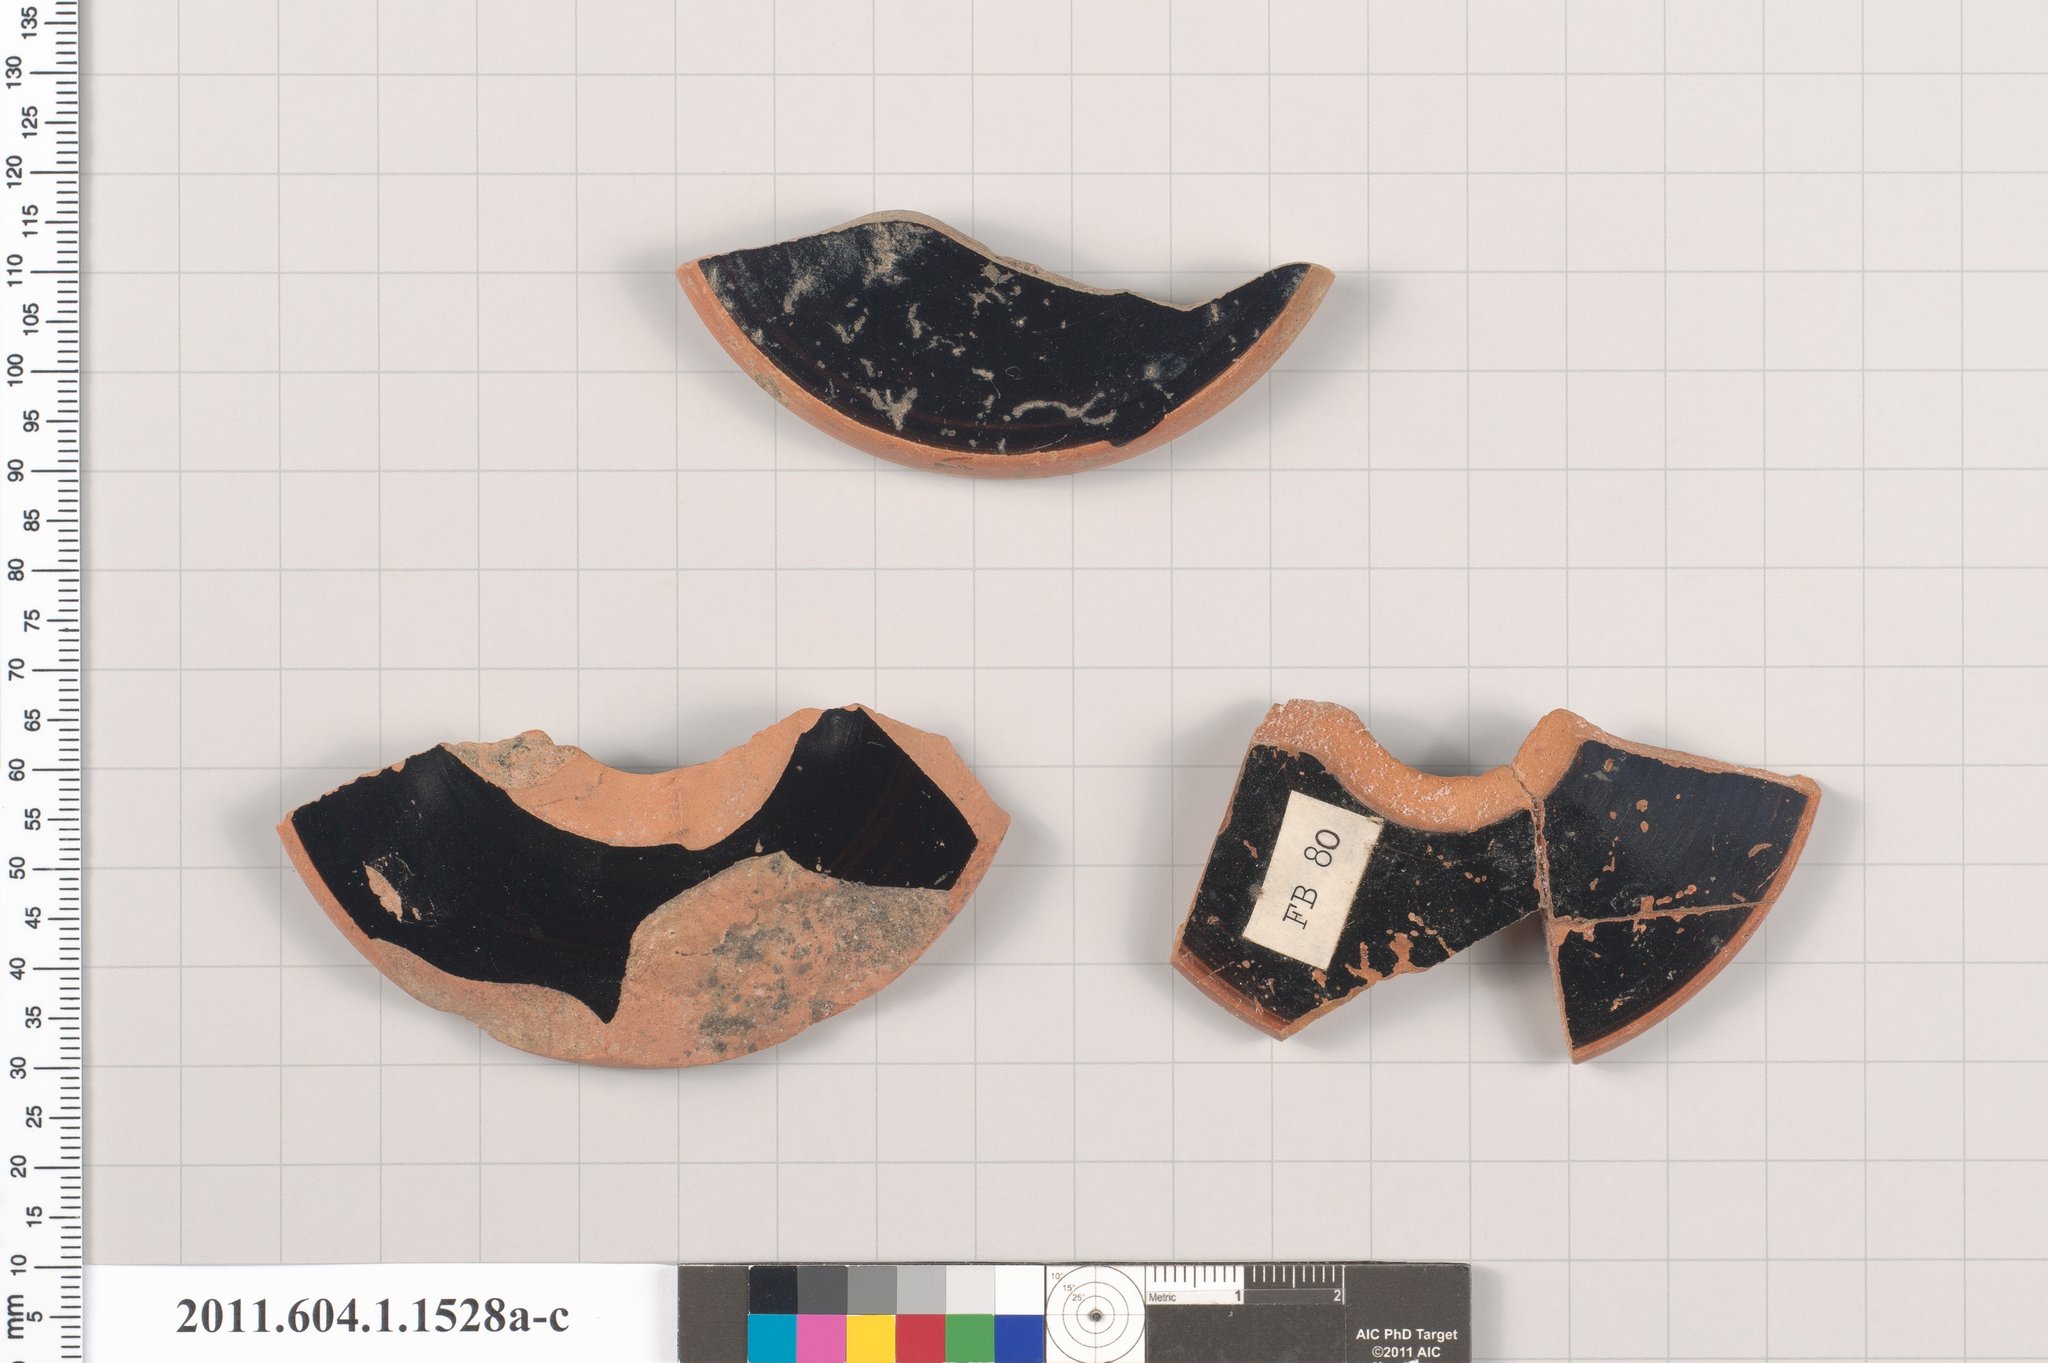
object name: kylix fragment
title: Terracotta fragments of kylikes (drinking cups)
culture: greek, attic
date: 500-401 BCE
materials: terracotta